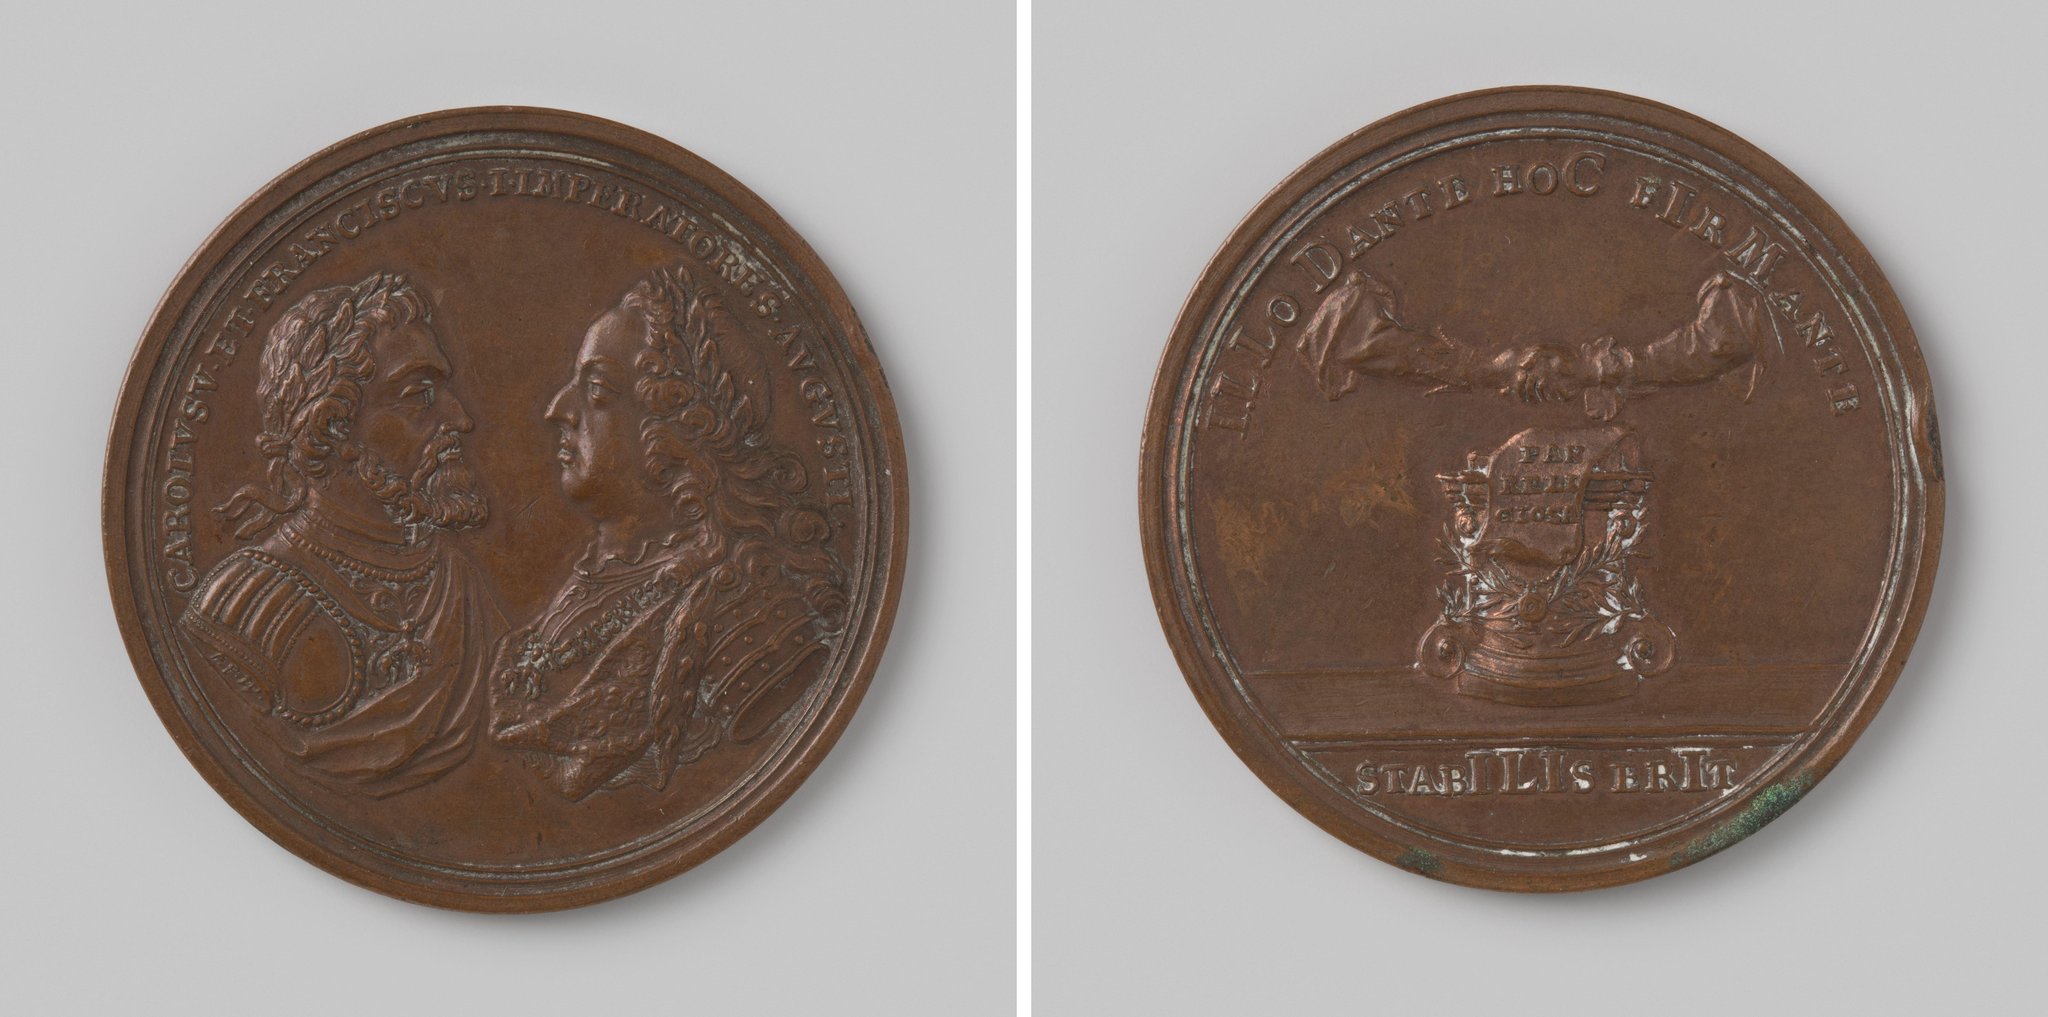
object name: history medal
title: Tweehonderdjarige herdenking van de godsdienstvrede tussen Karel V en Frans I 1755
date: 1755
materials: copper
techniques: striking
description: Koperen penning, op de voorzijde de elkaar toegewende borstbeelden van Karel V en Frans I met omschrift, op de keerzijde ineengeslagen handen boven een altaar met een oorkonde, met omschrift en afsnedetekst.